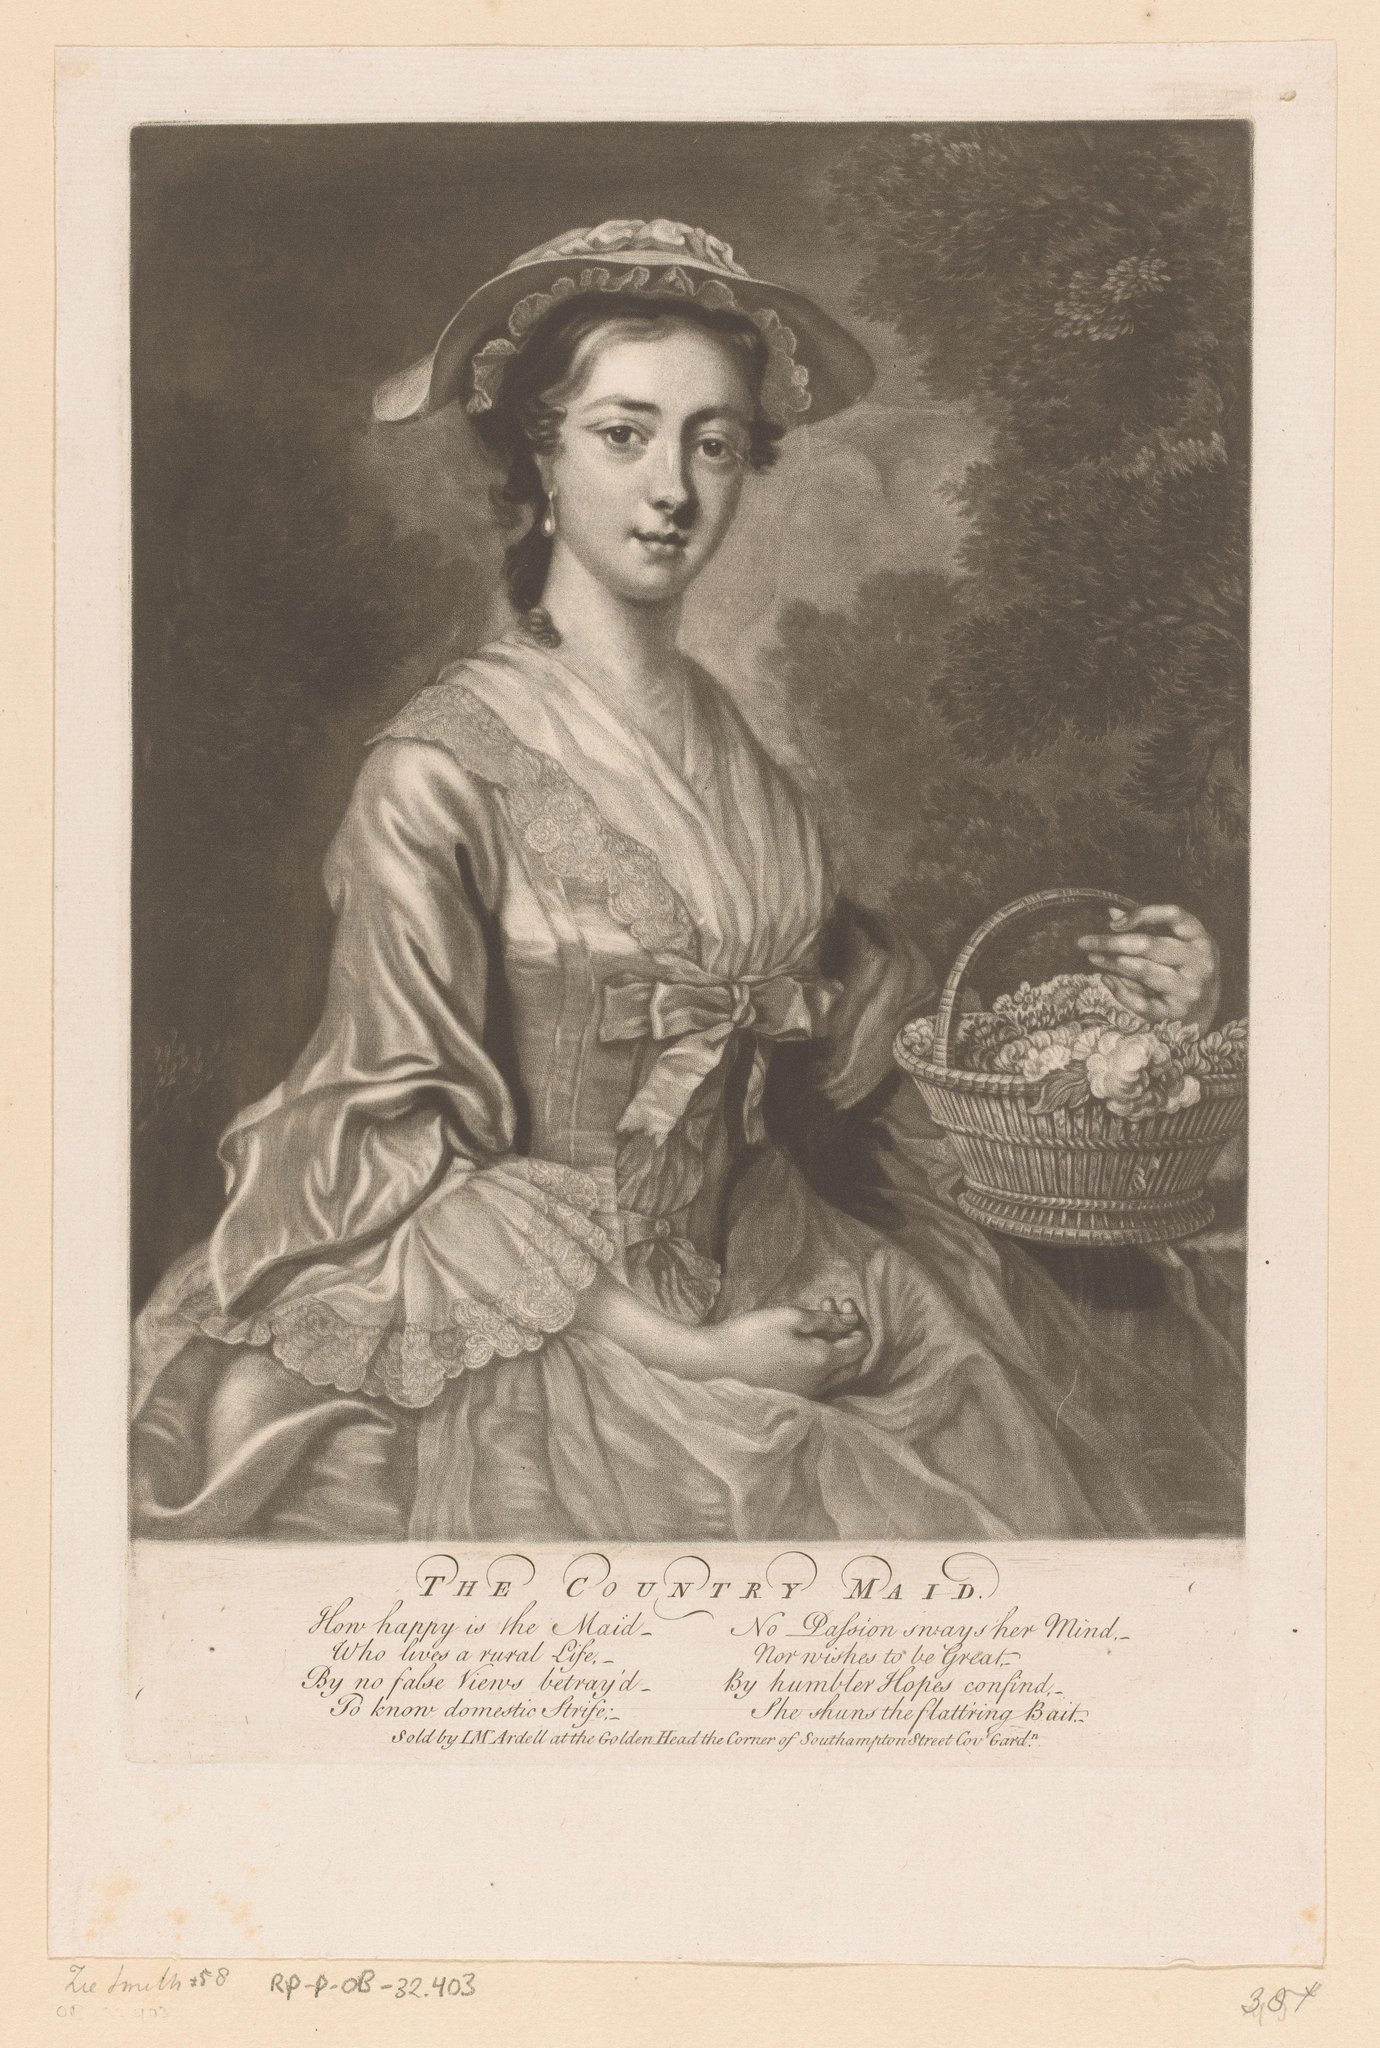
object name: print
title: Portret van Lucy Ebberton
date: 1745-1765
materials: paper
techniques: mezzotint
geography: london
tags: cut flowers; nosegay, bunch of flowers, historical persons - bb - woman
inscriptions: collector's mark: Lugt 240